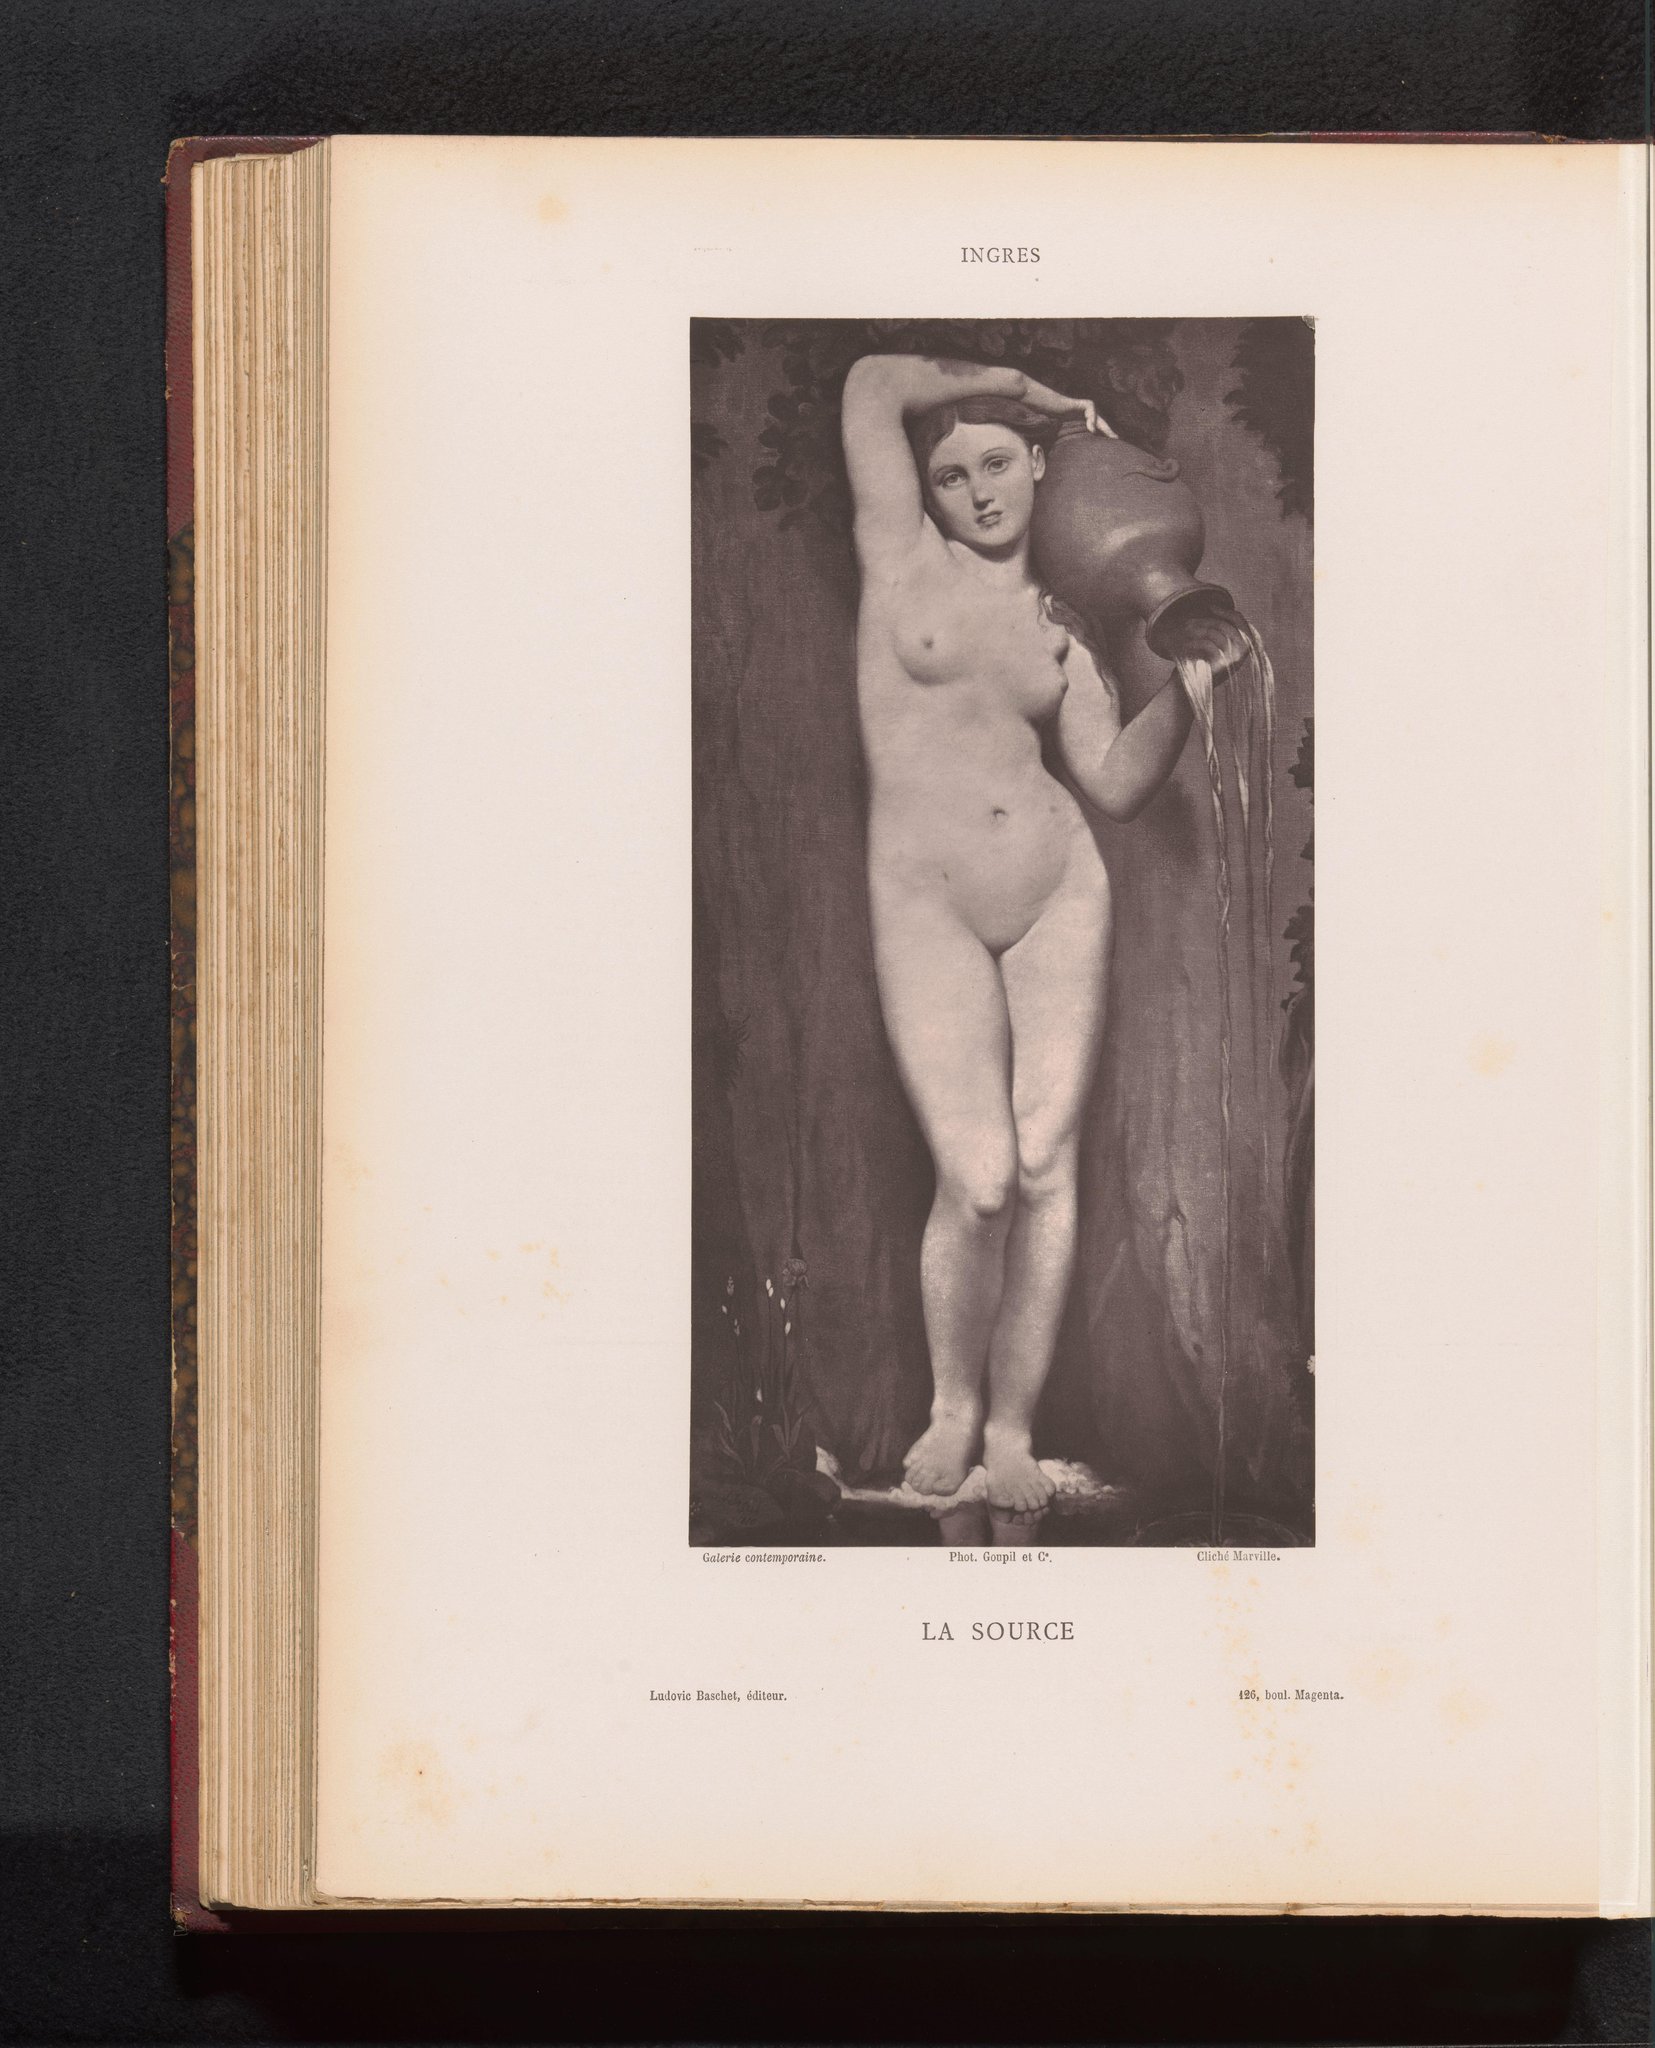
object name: page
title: Reproductie van La source door Jean Auguste Dominique Ingres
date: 1873-1878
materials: paper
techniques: woodburytype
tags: 'décolleté', container of ceramics: jar, jug, pot, vase, painting, drawing and the graphic arts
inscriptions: inscription: ‘Ingres/ Galerie Contemporaine/ Ludovic Baschet, éditeur./ 126 boul. Magenta.’